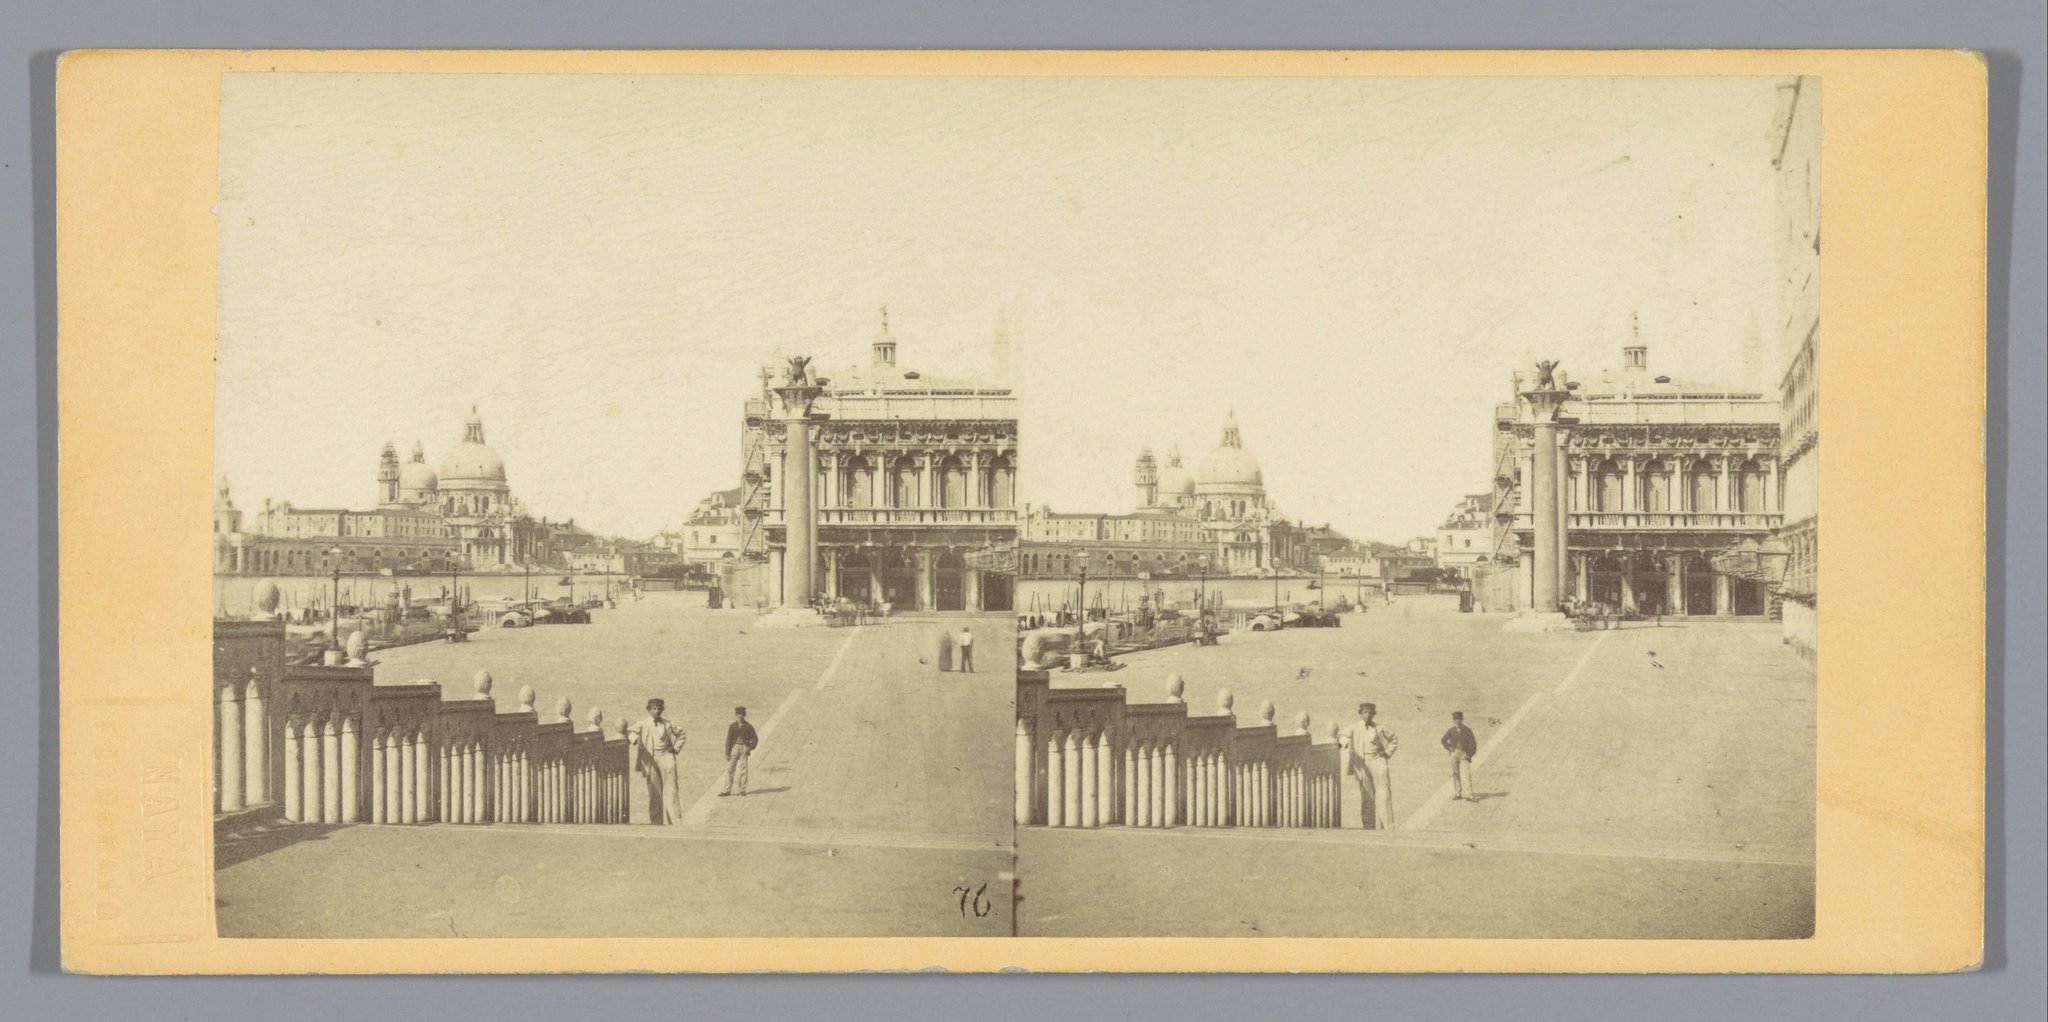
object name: stereograph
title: Gezicht op Venetië vanaf de Ponte della Paglia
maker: carlo naya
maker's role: fotograaf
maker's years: 1816-1882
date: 1850-1880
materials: cardboard, photographic support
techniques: albumen print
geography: venice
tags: city-view, and landscape with man-made constructions, bridge in city across river, canal, etc., venice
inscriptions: inscription: ‘Venezia Veduta preza dal Ponte della Paglia Ansicht aufgenommen von der Strohbrücke’, number: ‘76’